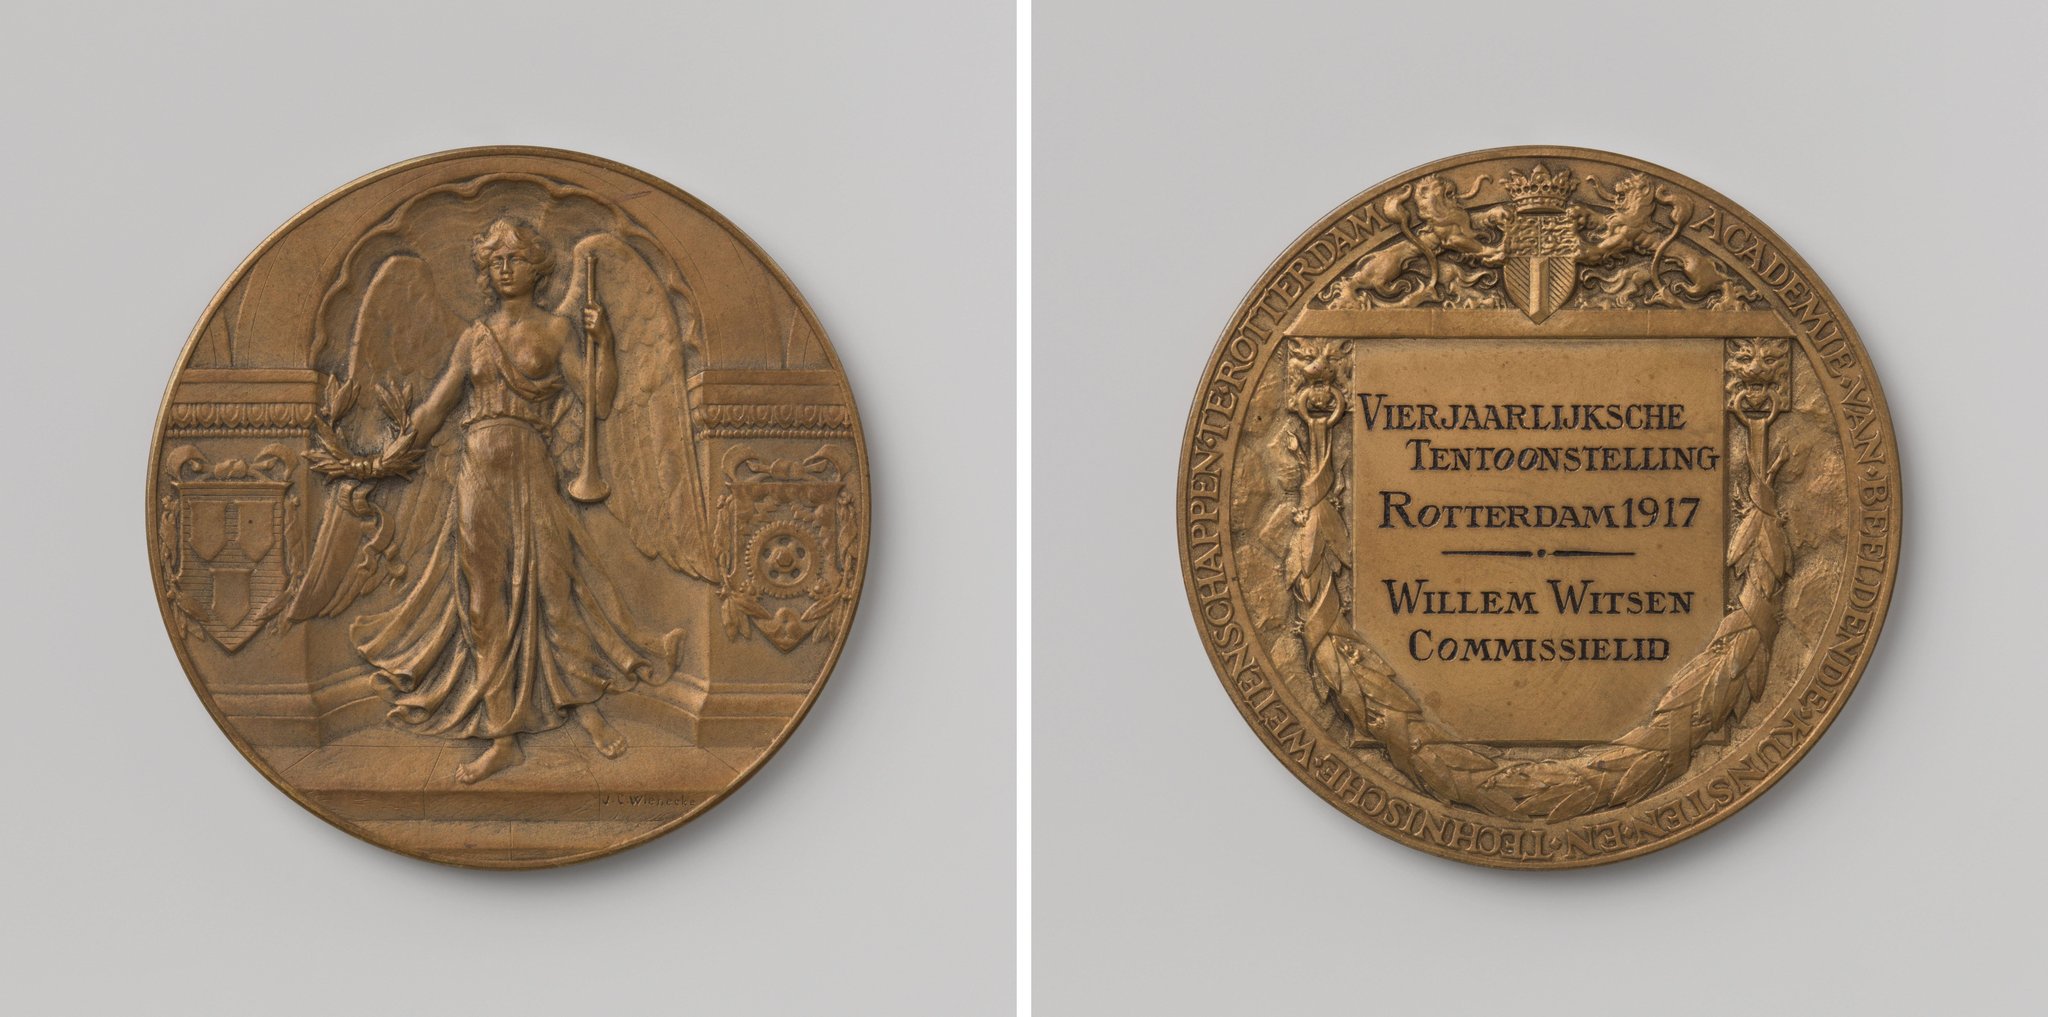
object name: honorary medal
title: Willem Witsen, commissielid van de vierjaarlijkse tentoonstelling van de Akademie van Beeldende Kunsten en Technische Wetenschappen te Rotterdam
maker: johannes cornelis wienecke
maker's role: medailleur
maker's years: 1872-1945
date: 1917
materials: bronze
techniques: engraving, striking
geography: utrecht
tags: amsterdam, painter, print maker, draughtsman, willem witsen, rotterdam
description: Bronzen penning. Voorzijde: gevleugelde vrouw met bazuin en lauwerkrans in handen, staande onder opening van boog, waarvan beide pilarenwapenschilden dragen; afsnede: signatuur. Keerzijde: opschrift, omhangen met lauwerkrans, onder gekroond wapenschild, geflankeerd door twee leeuwen binnen omschrift.